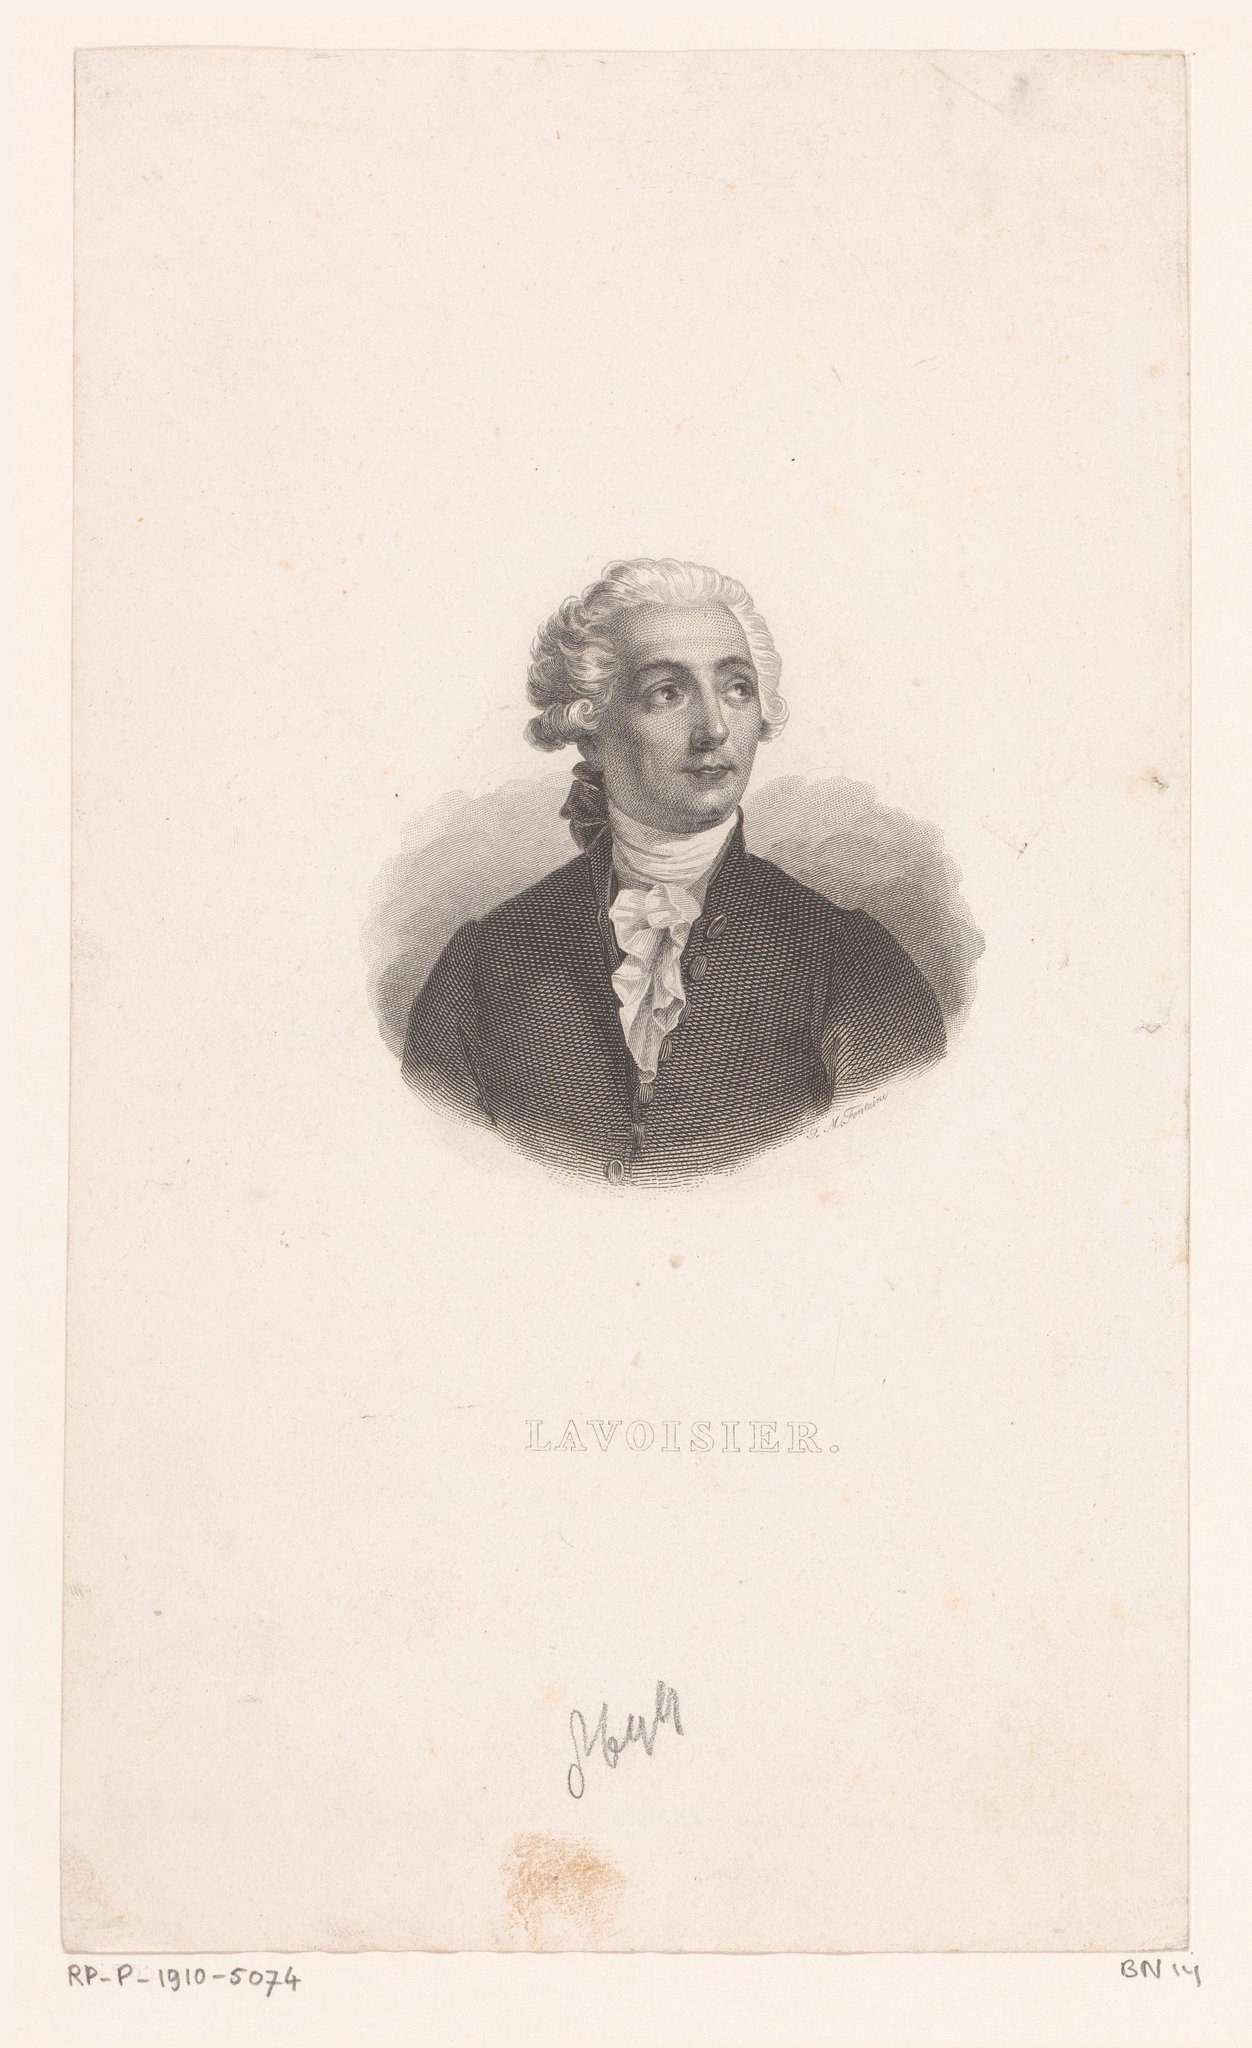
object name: print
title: Portret van Antoine Laurent Lavoisier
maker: jean mathias fontaine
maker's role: print maker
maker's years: 1791-1853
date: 1830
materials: paper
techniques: engraving, etching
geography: france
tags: paris, scholar, philosopher, historical persons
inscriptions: collector's mark: Lugt 2228